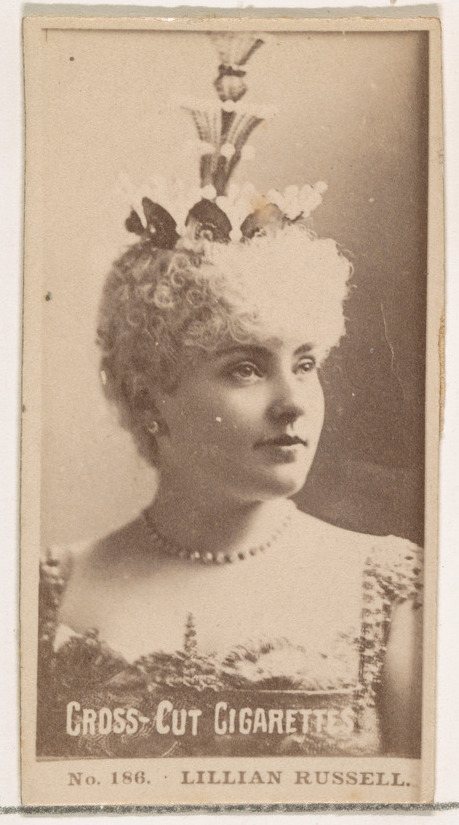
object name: print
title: Card Number 186, Lillian Russell, from the Actors and Actresses series (N145-2) issued by Duke Sons & Co. to promote Cross Cut Cigarettes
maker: w. duke, sons & co.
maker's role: publisher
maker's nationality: american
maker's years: 1870-1920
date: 1880-1889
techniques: albumen silver print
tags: portraits,women,actresses